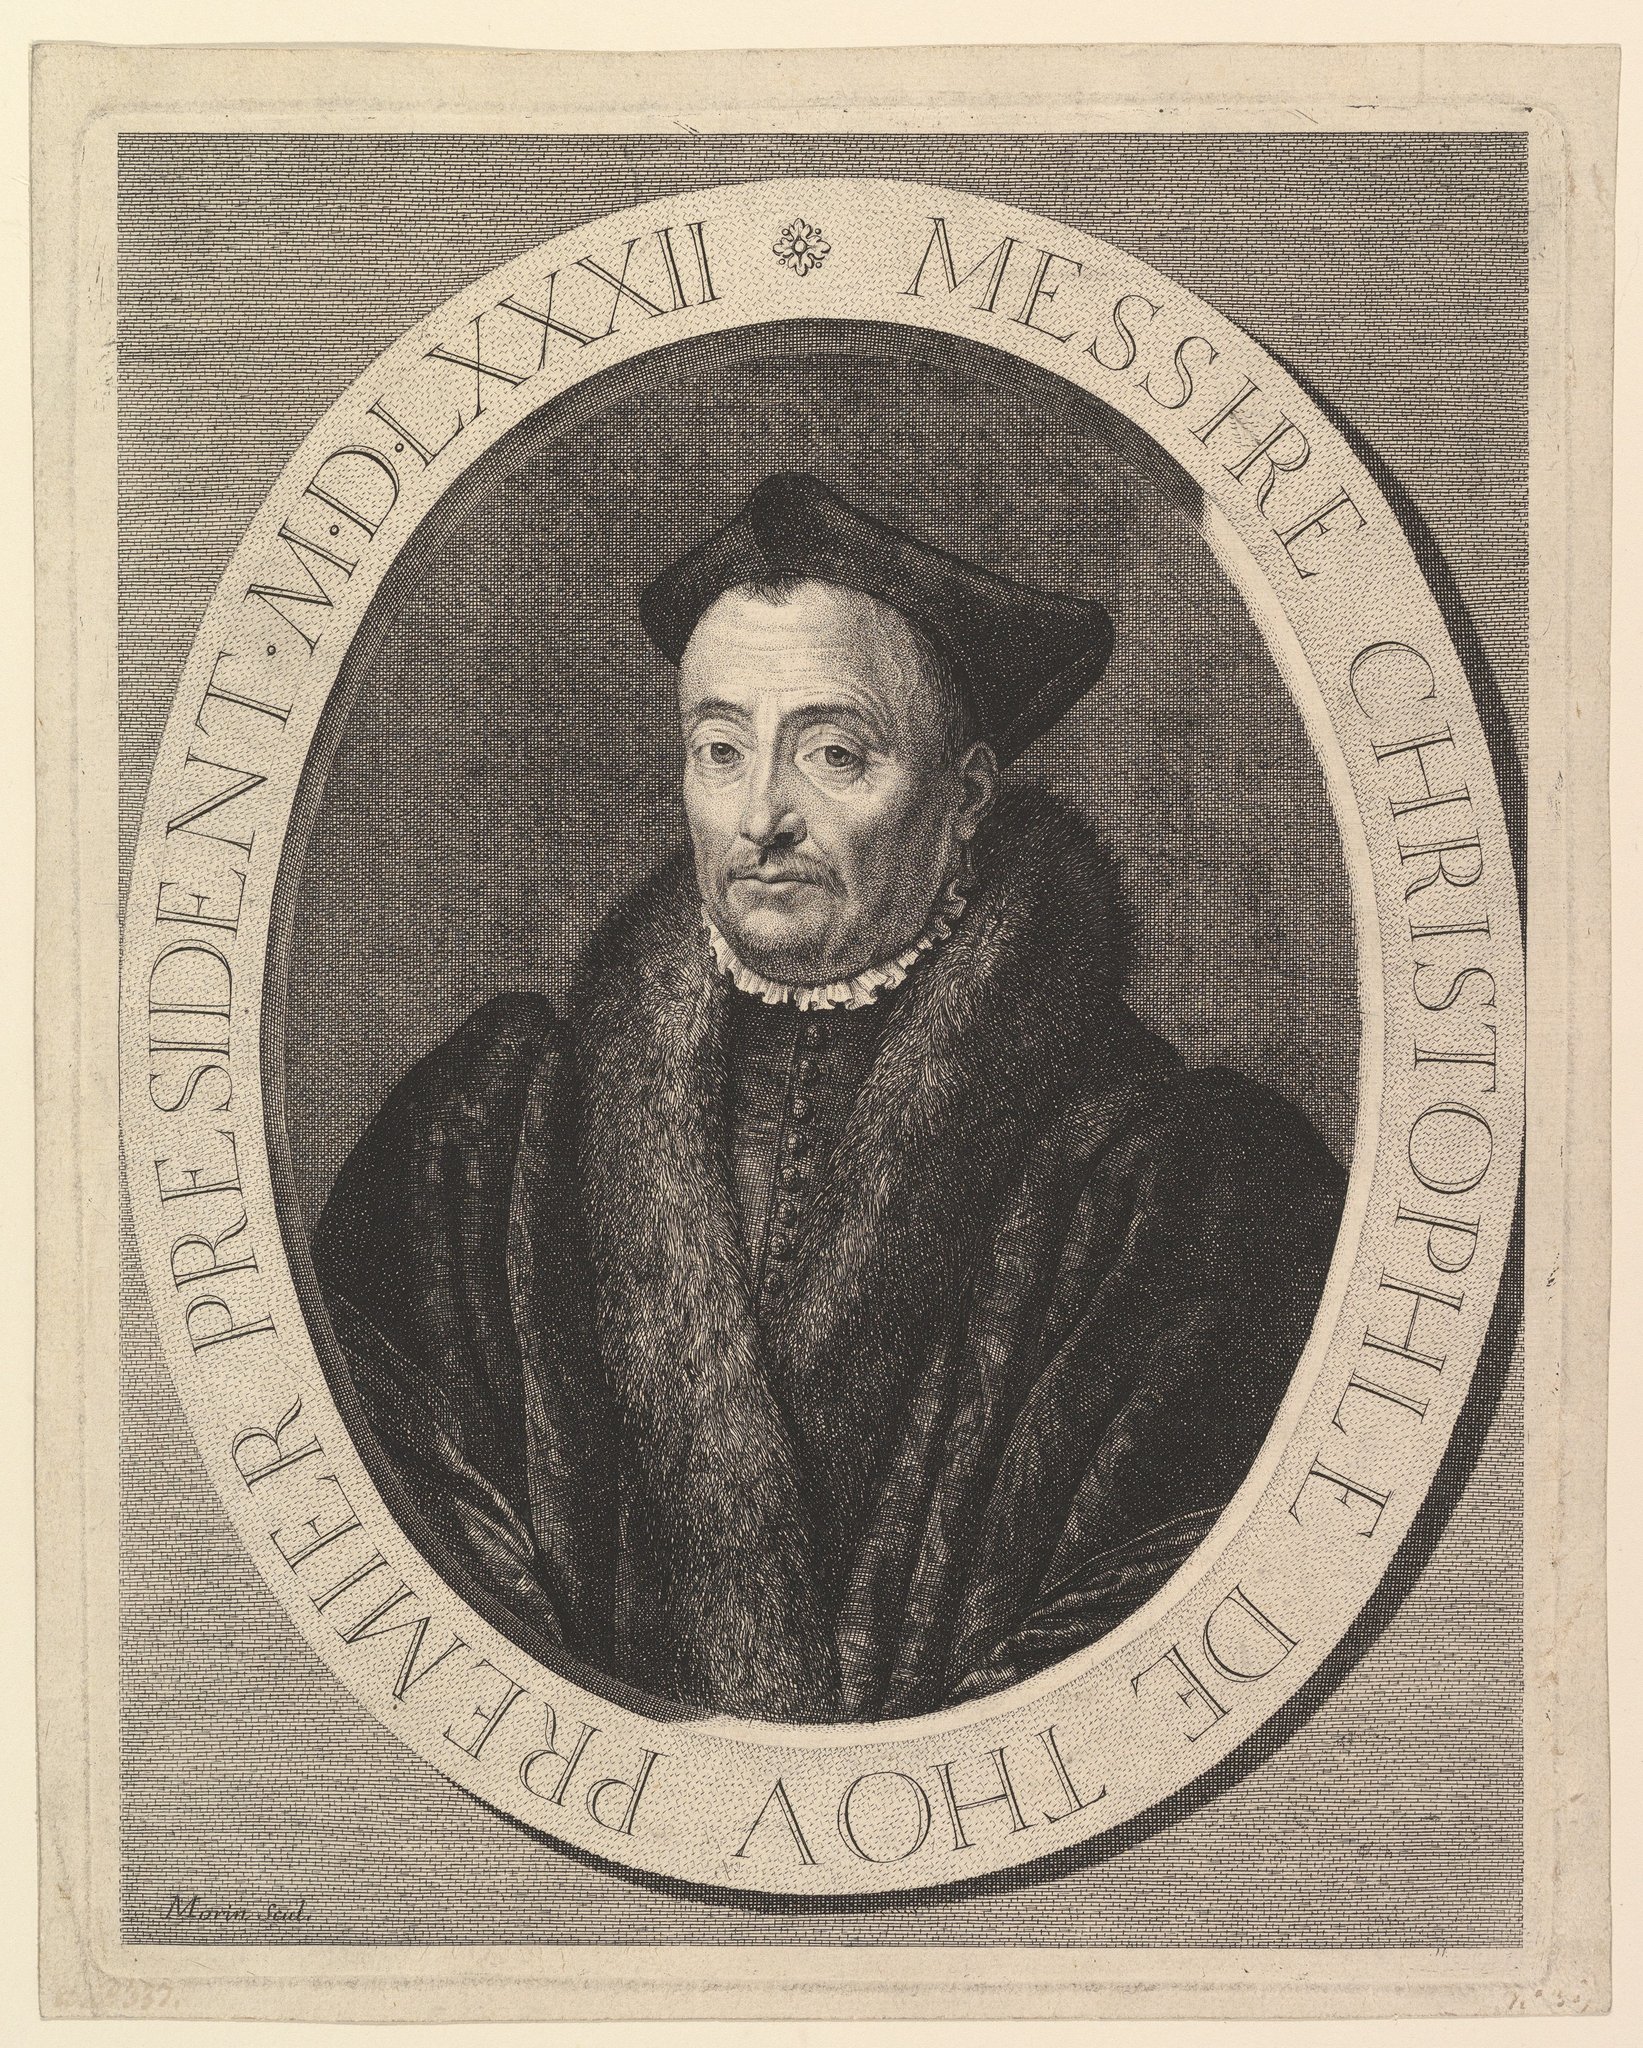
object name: print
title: Christophe de Thou, premier president au Parlement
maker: jean morin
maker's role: artist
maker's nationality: french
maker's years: 1605-1650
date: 1605-1650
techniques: etching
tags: men,portraits